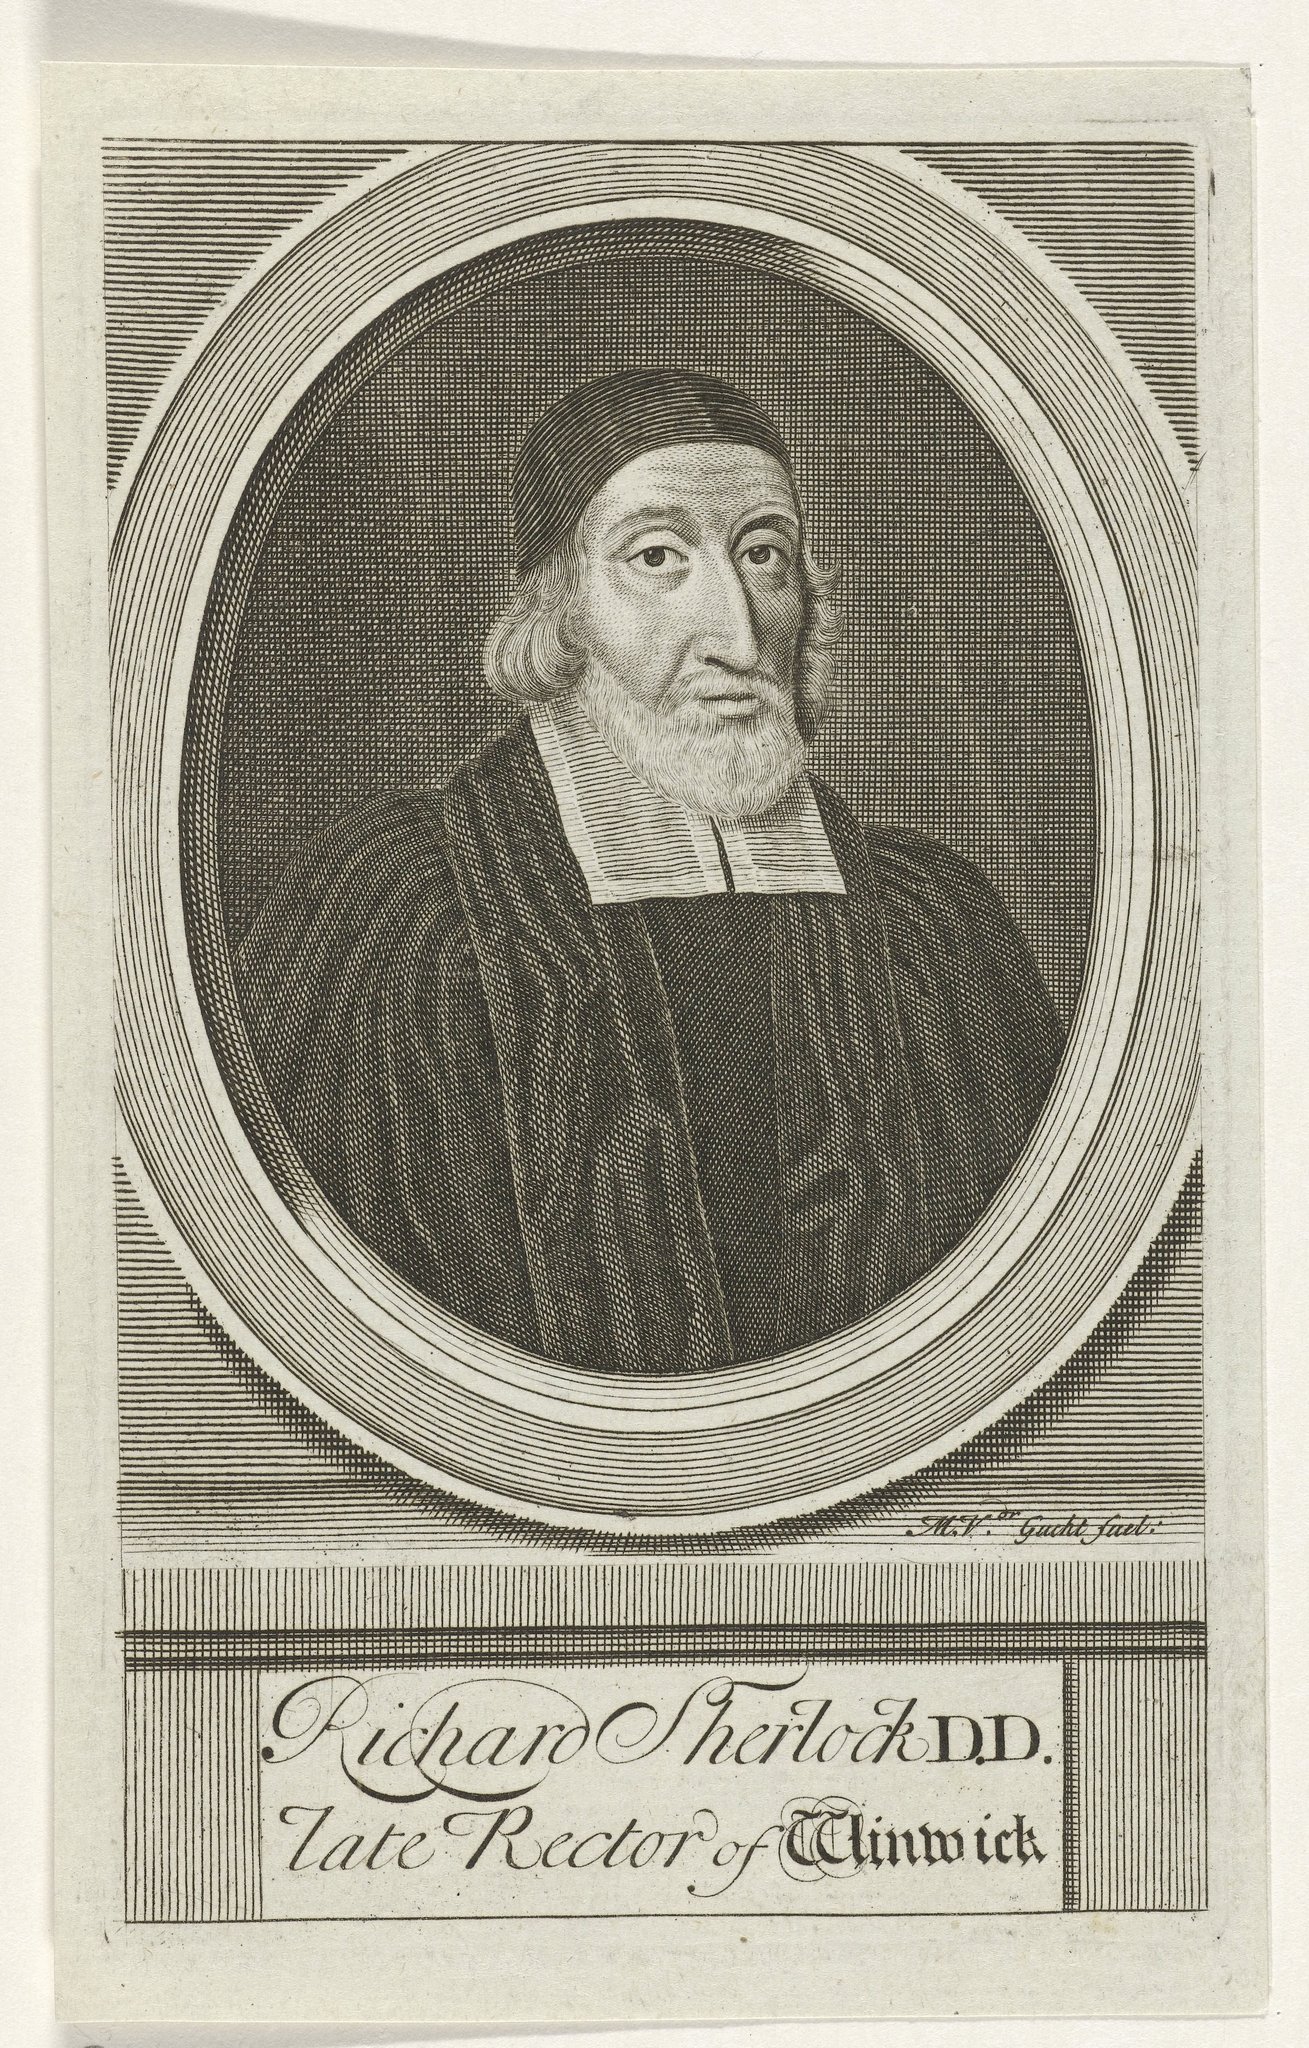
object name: print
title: Portret van Richard Sherlock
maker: michiel van der gucht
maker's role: print maker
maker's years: 1660-1725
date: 1670-1725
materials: paper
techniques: engraving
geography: antwerp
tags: rector, richard sherlock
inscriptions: collector's mark: Lugt 2228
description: Portret van Richard Sherlock, met bef en kalot. Het portret is gevat in een ovale omlijsting. In de marge de naam en functie van de geportretteerde.